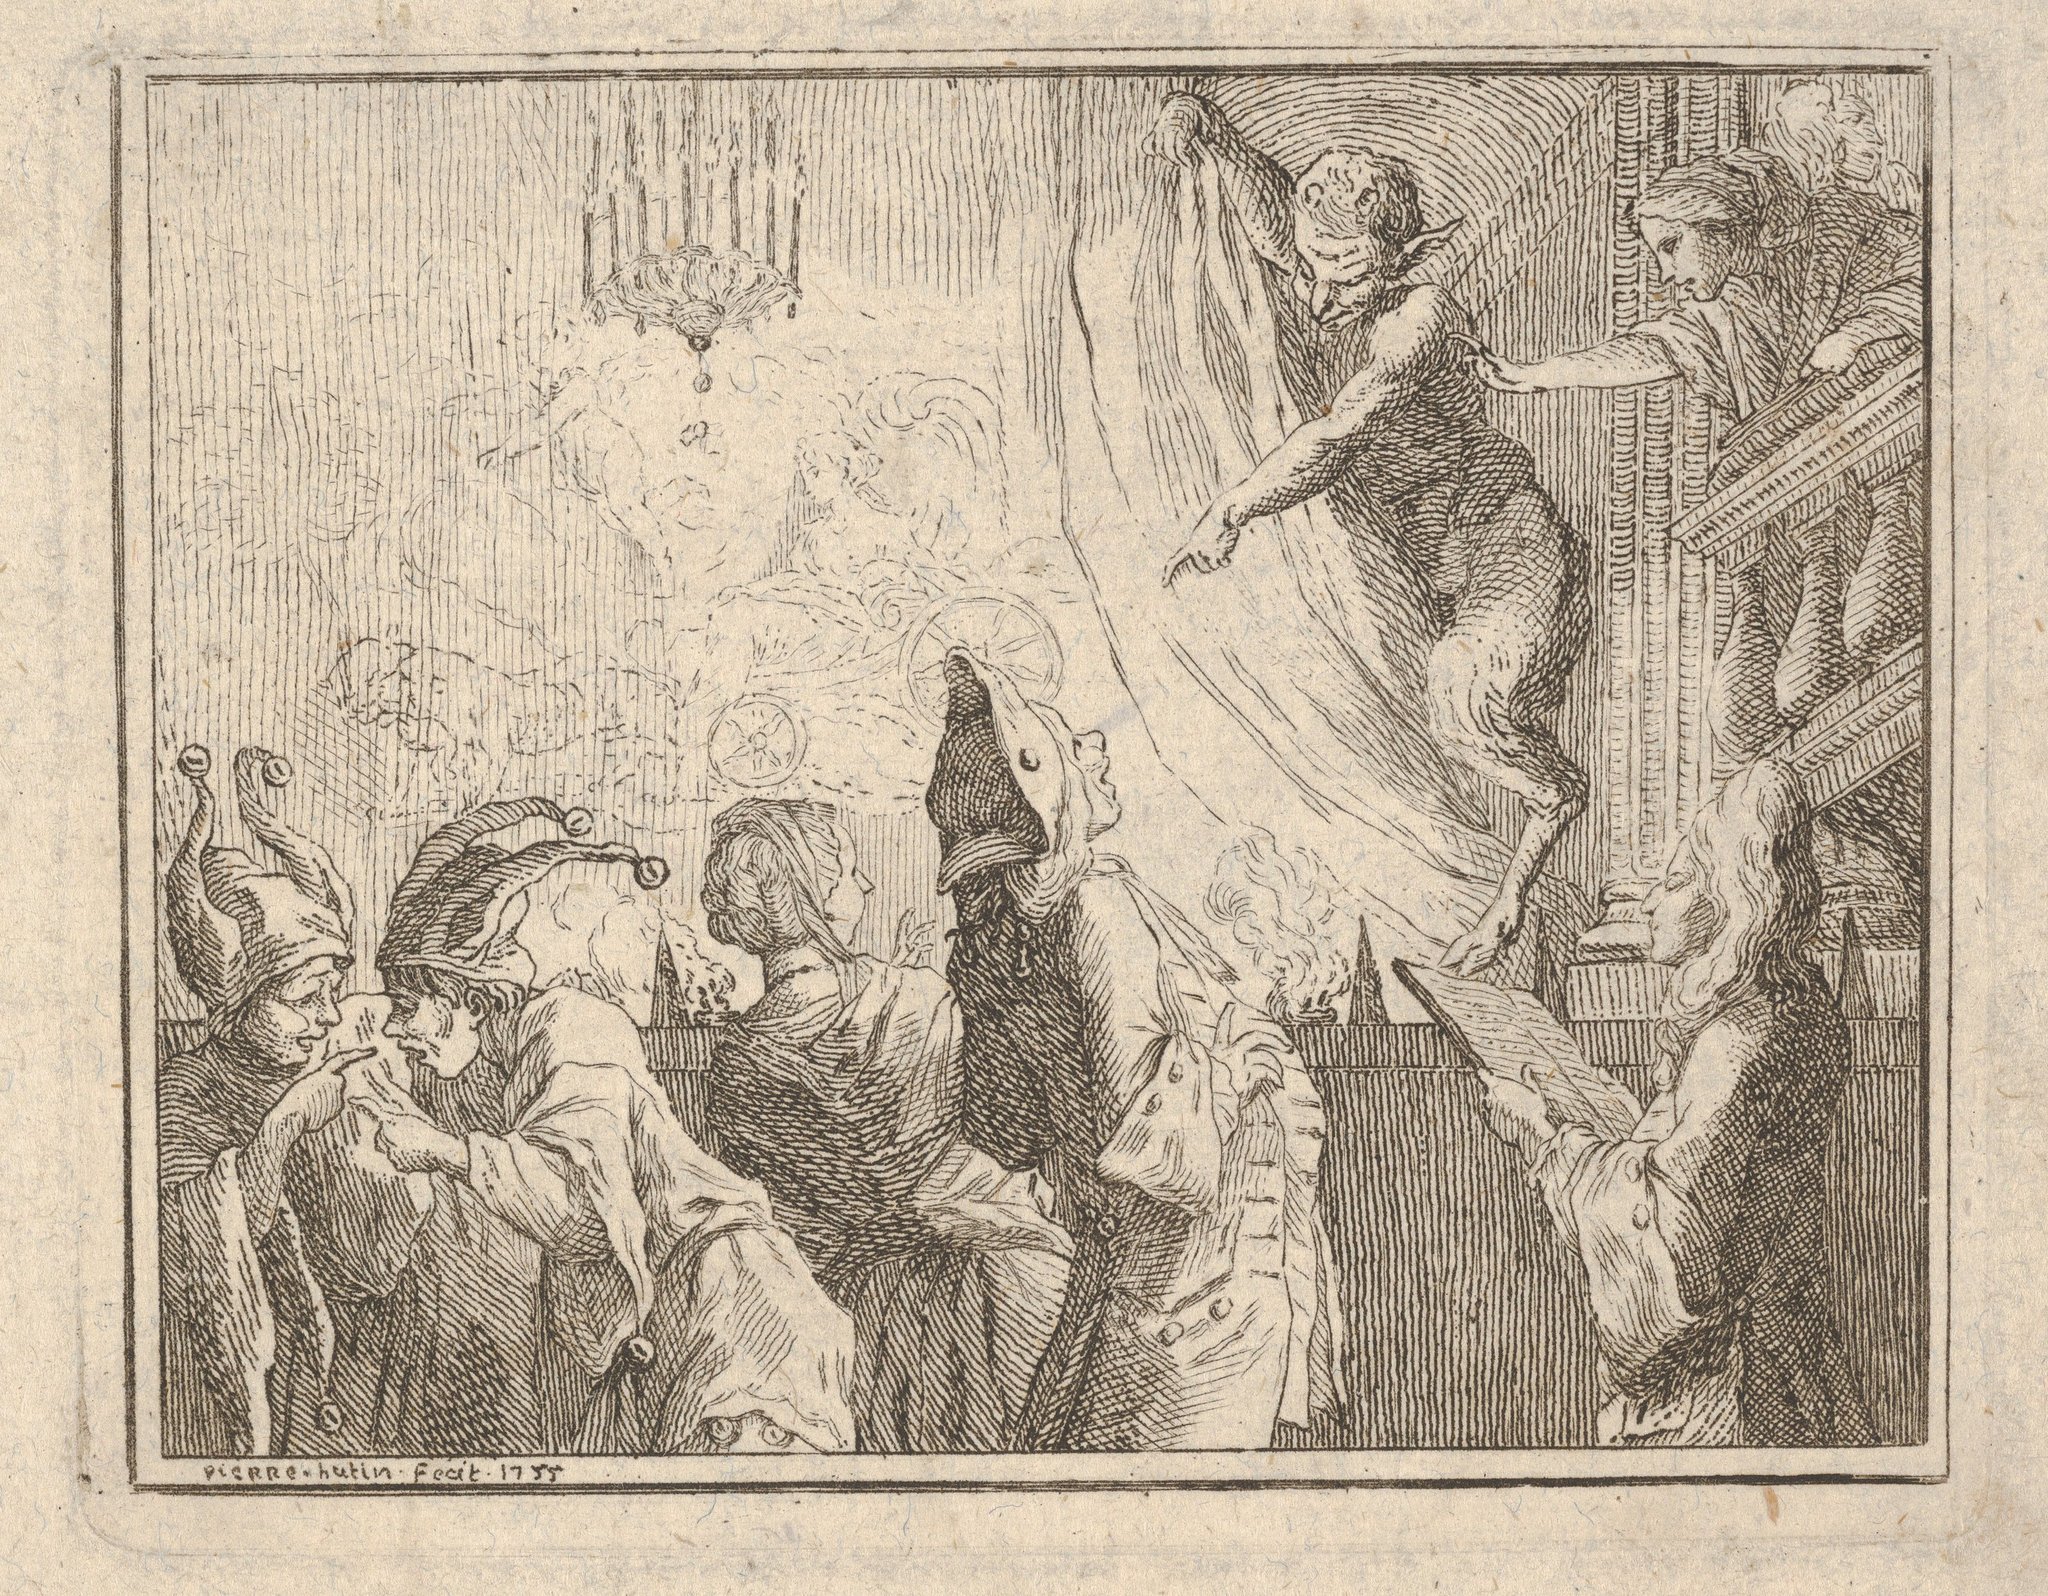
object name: print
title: Satyr standing on a stage and pointing downward toward an audience, two jesters gesticulate at lower left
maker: pierre hutin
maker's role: artist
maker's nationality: french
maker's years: 1720-1763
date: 1755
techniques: etching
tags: men,women,spectators,satyrs